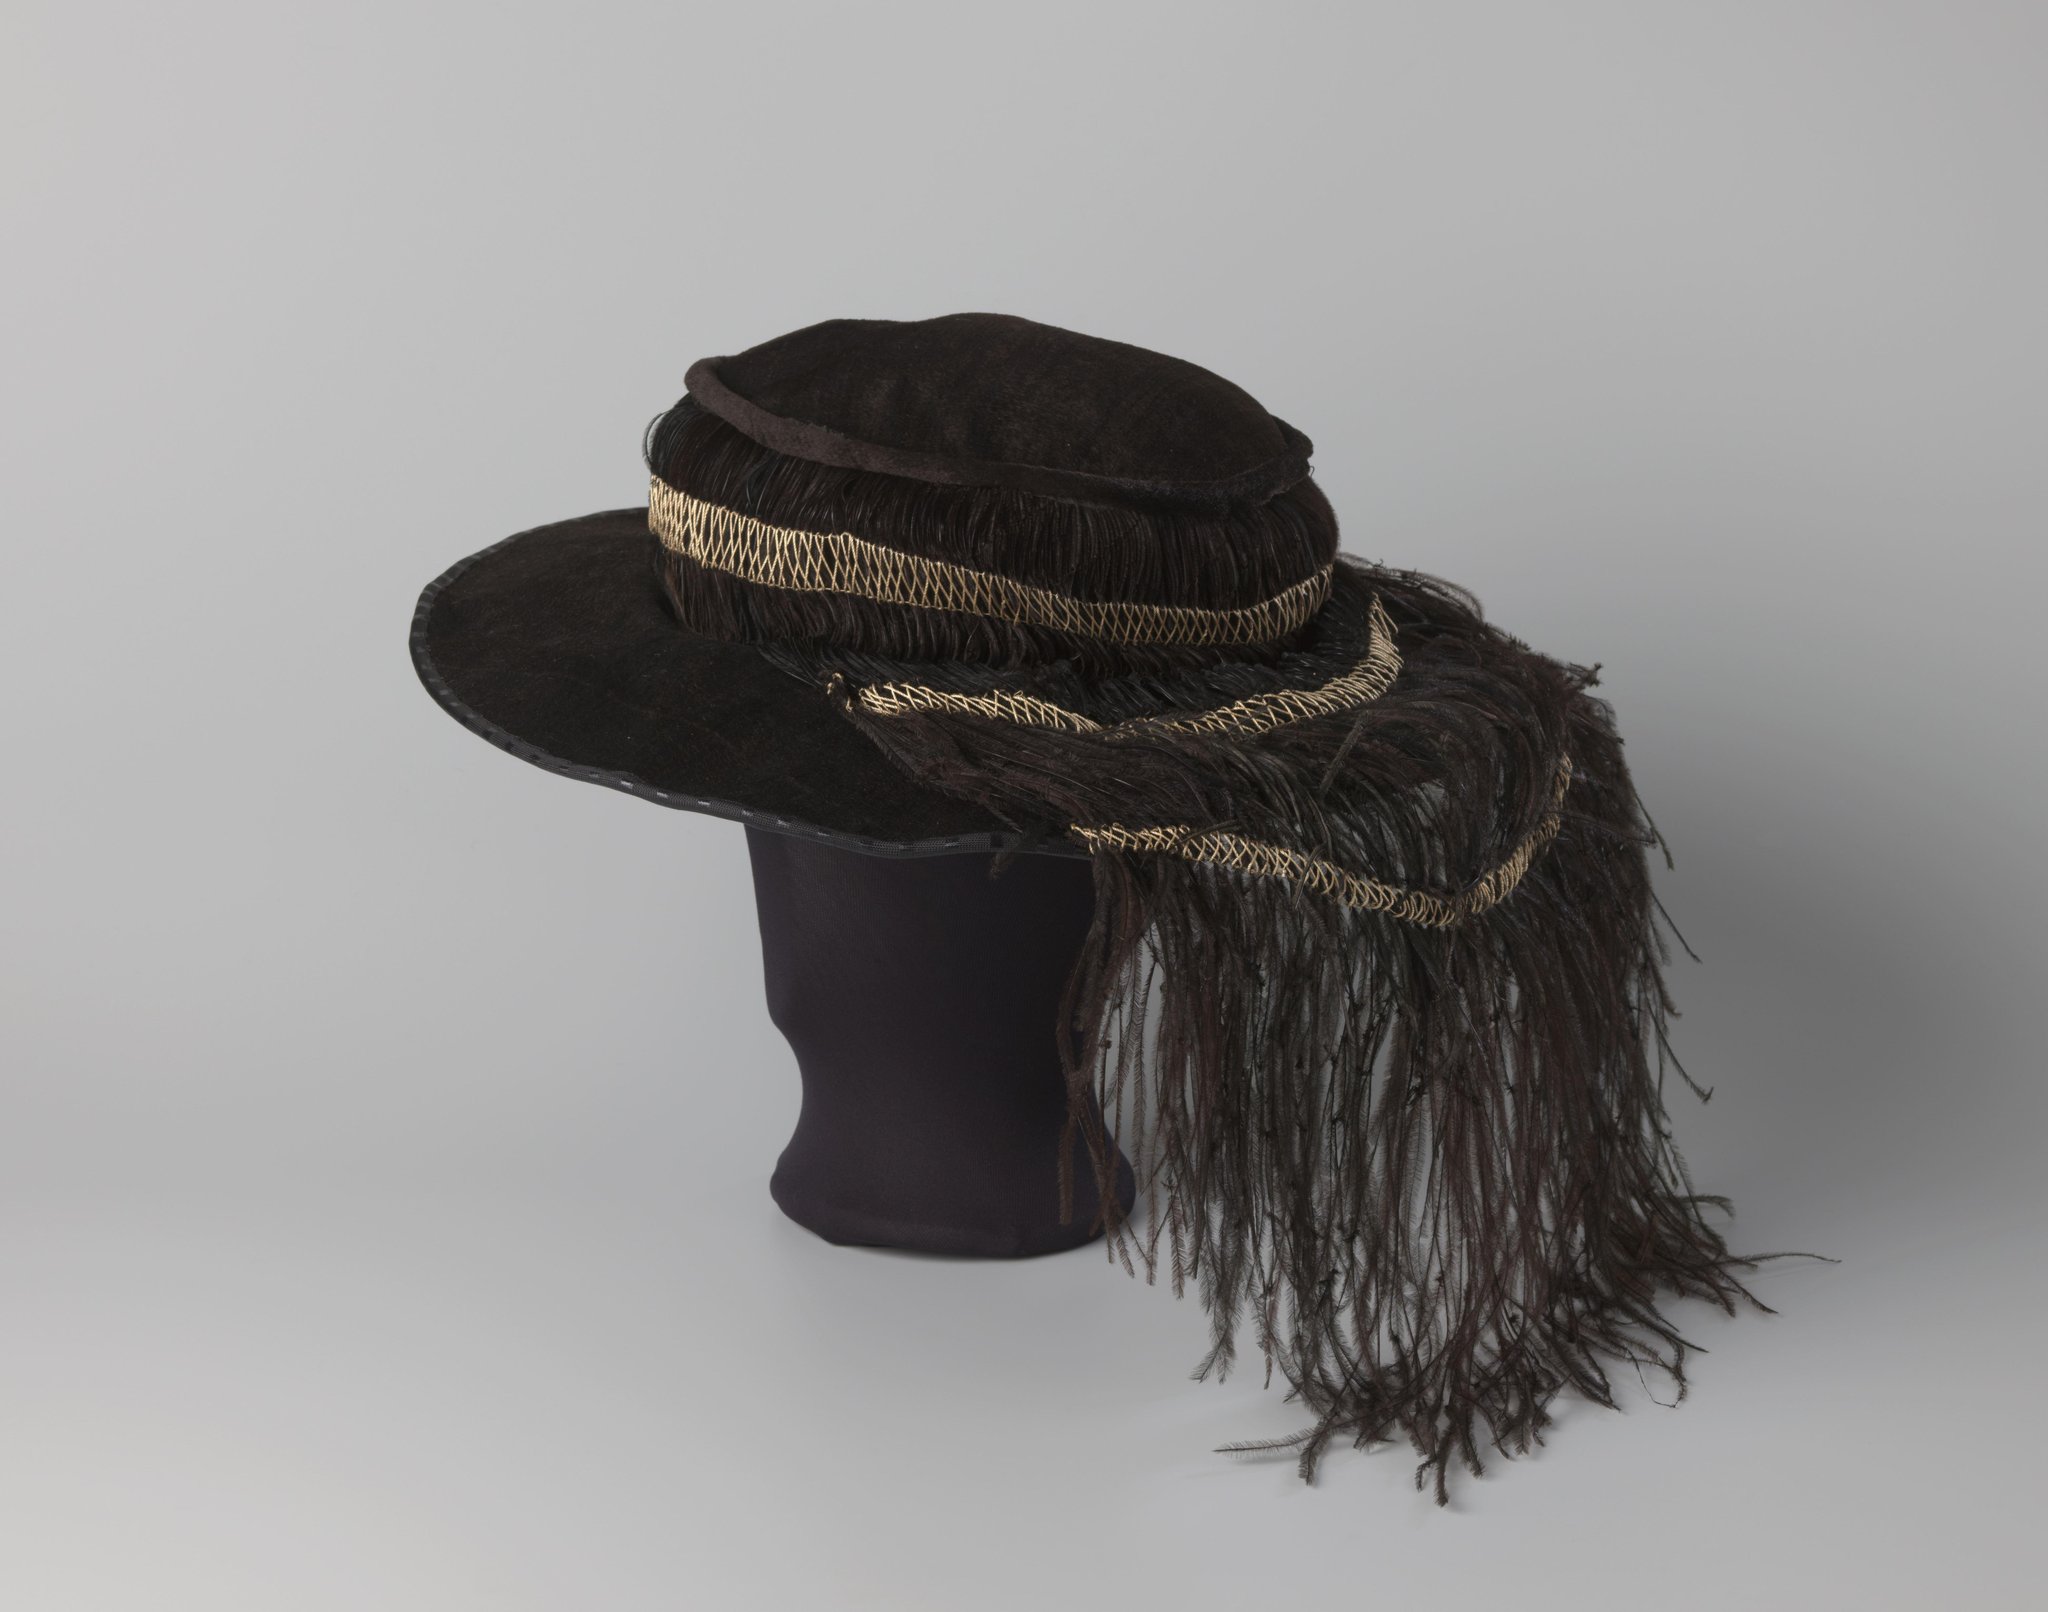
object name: hat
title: Hoed van zwart fluweel met band van stuisvogelveren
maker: madame haggelin hilletard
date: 1912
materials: velvet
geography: paris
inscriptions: mark: ‘PARIS / Mme Vaggelin-Villetard / 1. Rue de Choiseul / PRÈS L'AVENUE L'AVENUE DE L'OPÉRA’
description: Dameshoed van zwart fluweel, de rand omboord met zwarte tres, om den bol een band samengesteld uit fragmenten van struisveren in het midden samengebonden door steken van crème zijden draad, dezelfde versiering van struisveren hangt van achteren in drie rijen. In de bol gemerkt: Paris Mme Haggelin Hilletard, 1 Rue de Choiseul, pres l'avenue de l'Opera.